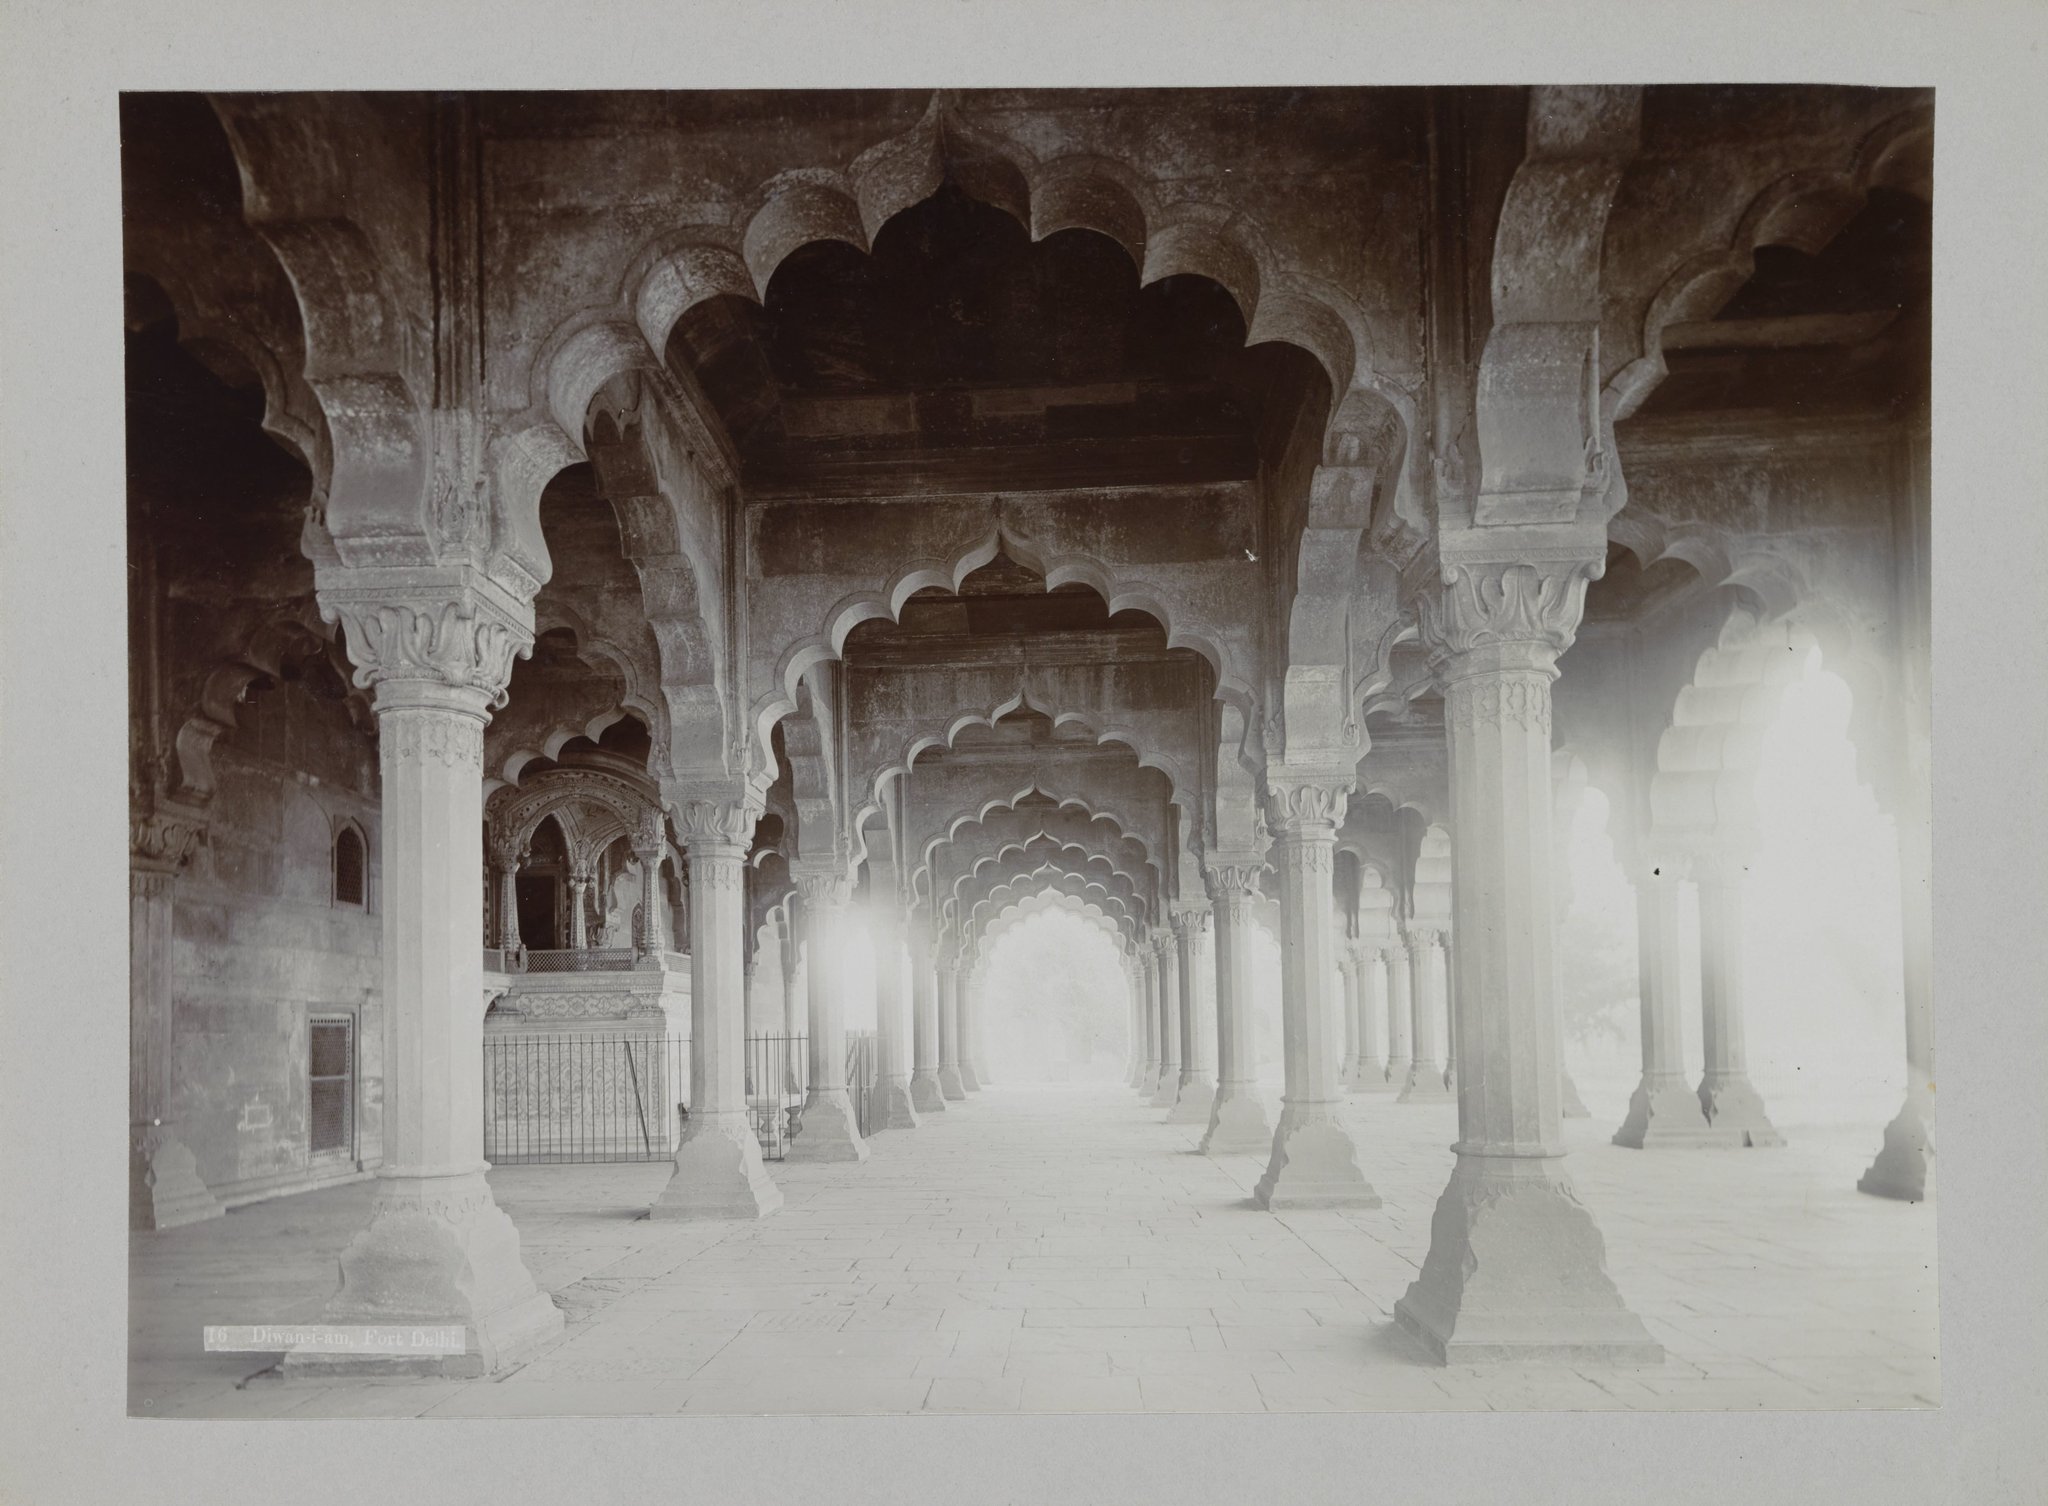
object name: photograph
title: Interior of the Diwan-i-am in the Red Fort at Delhi, India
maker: Anonymous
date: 1895-1915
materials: cardboard, paper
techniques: gelatin silver print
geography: delhi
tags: delhi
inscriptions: number: ‘32.’, inscription: ‘16 Diwan-i-am, Fort Delhi.’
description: De Zaal der Openbare Audiënties (Diwan-i-am) bevindt zich binnen het Rode Fort van Delhi.